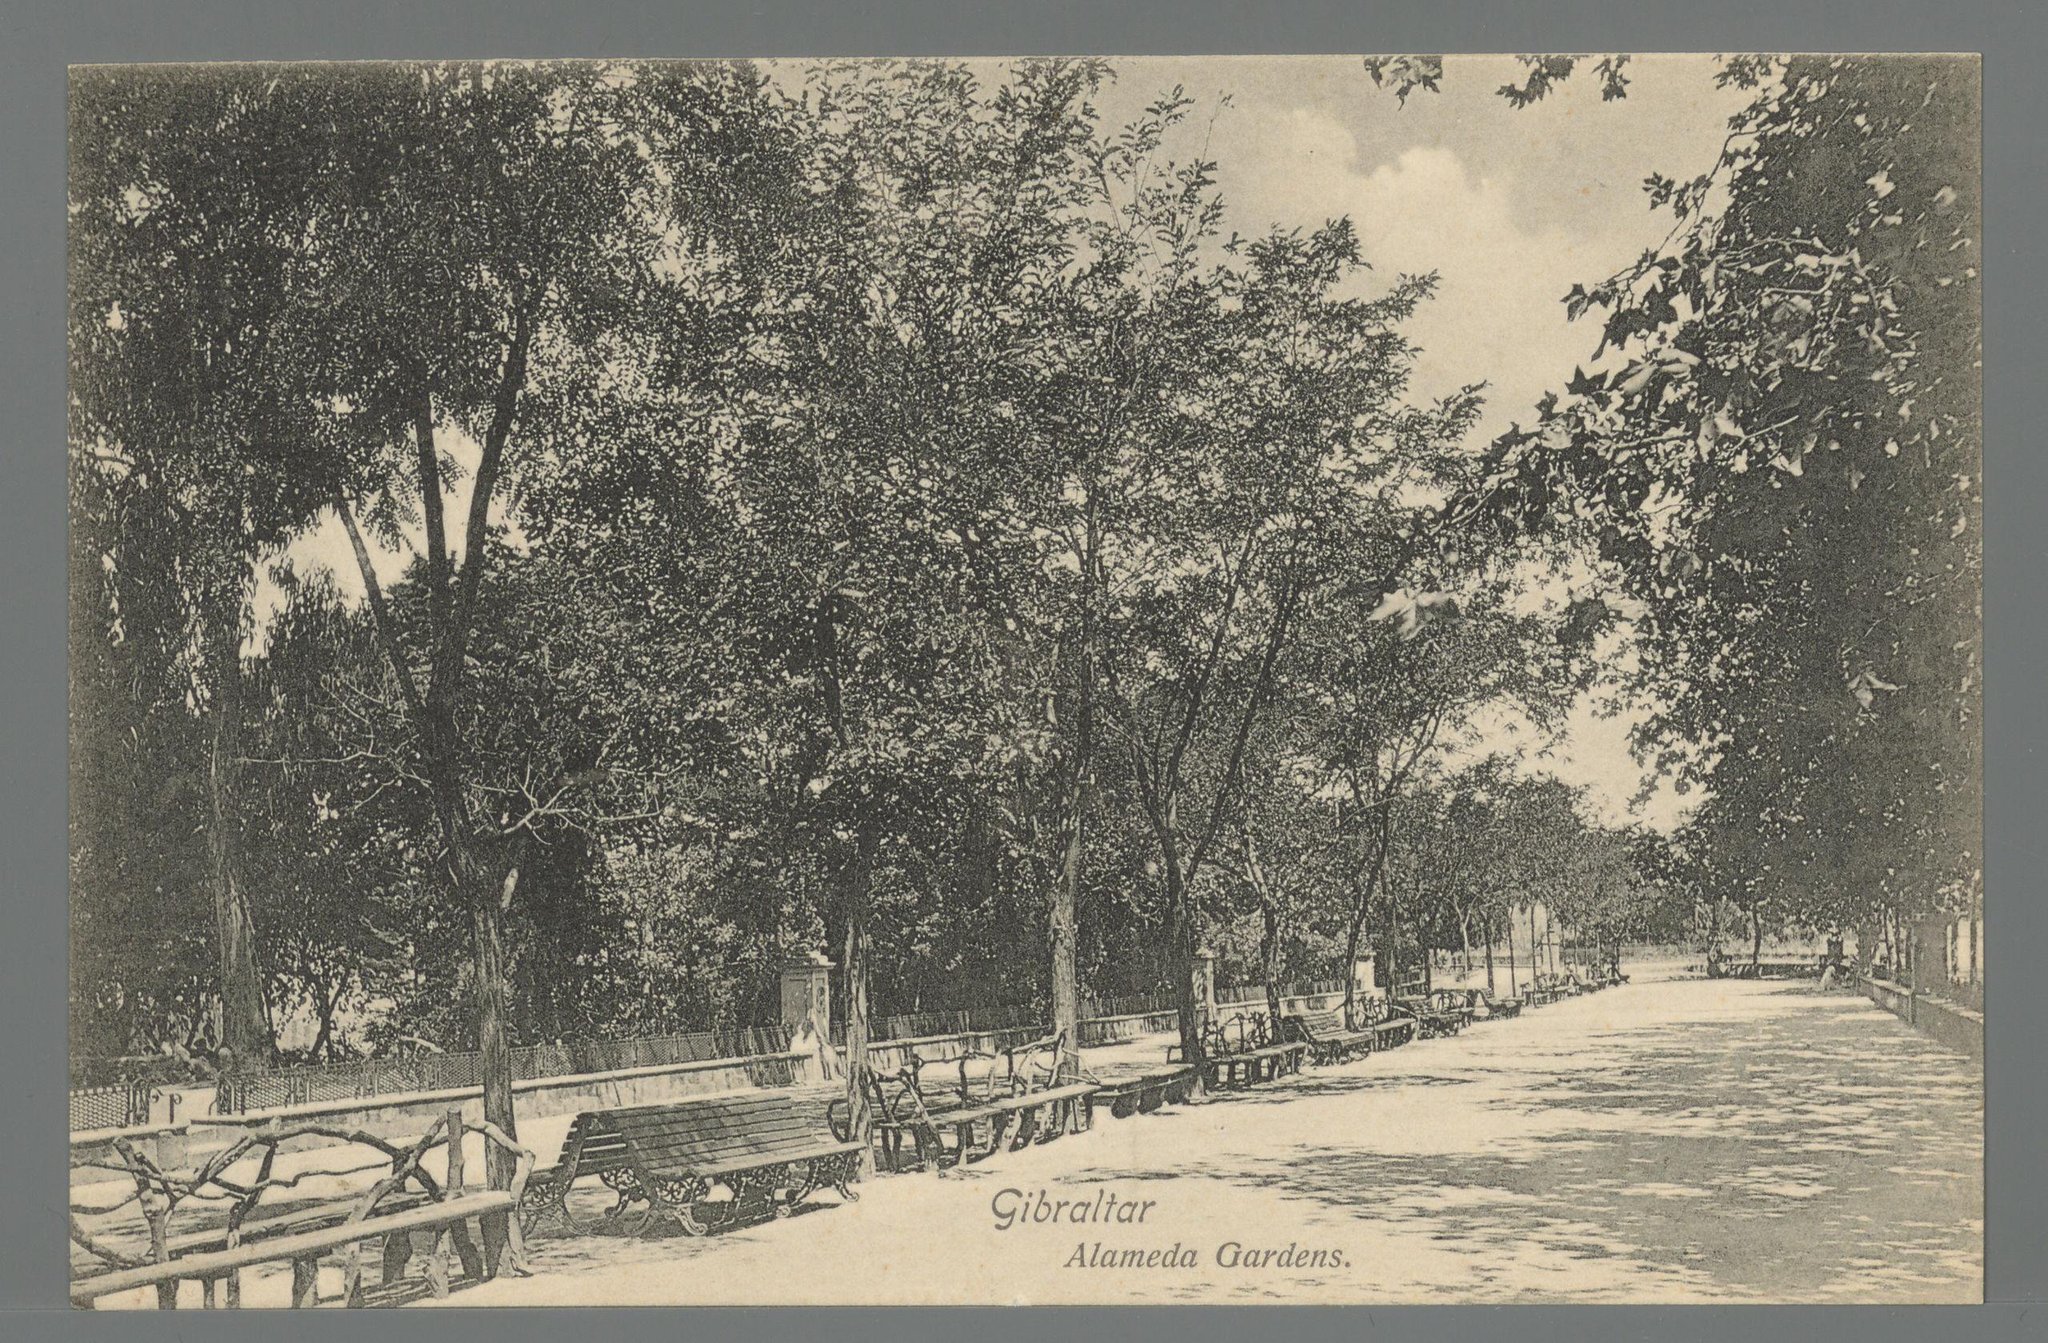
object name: ansichtkaart, prentbriefkaart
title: Gibraltar. Alameda Gardens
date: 1906-1930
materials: cardboard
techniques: photograph, writing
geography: saxony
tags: bench, botanic garden, 'hortus botanicus'